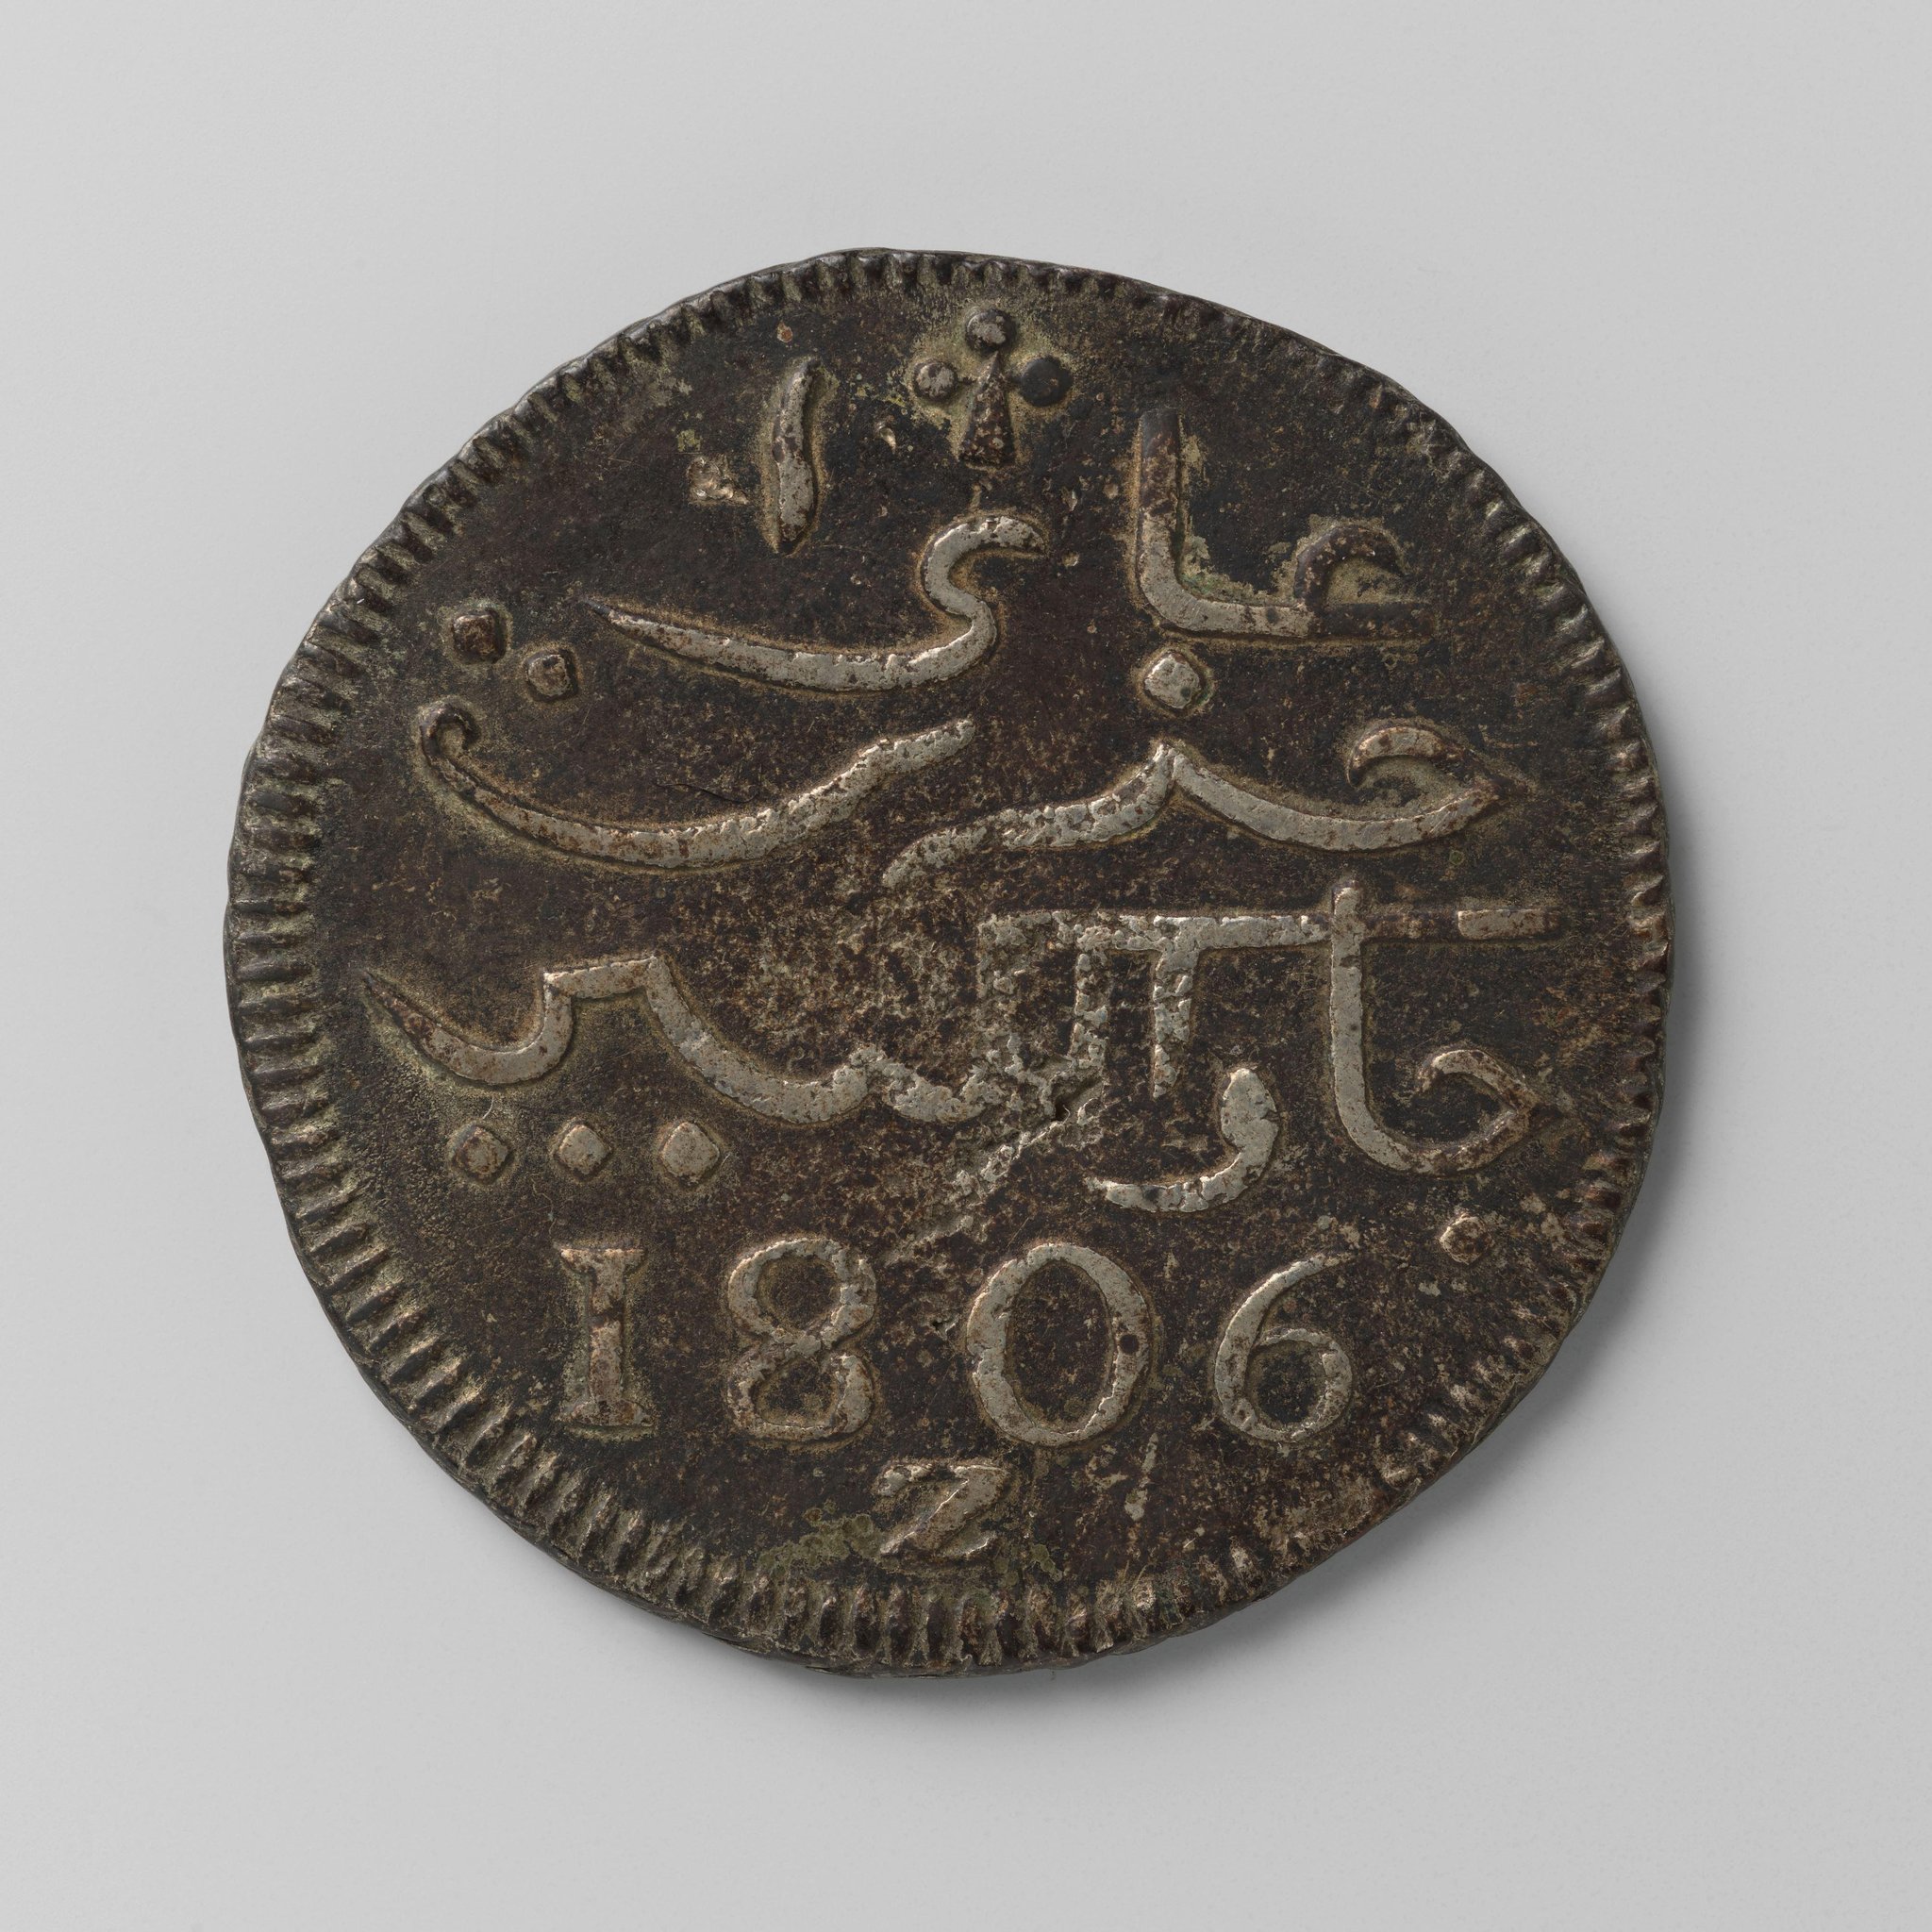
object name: ropij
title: Zilveren ropij van Nederlands Indië uit Java, 1806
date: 1806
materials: silver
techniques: striking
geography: batavia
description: Zilveren munt. Voorzijde: drieregelig opschrift in Arabische letters. Daarboven muntteken en daaronder jaartal, waaronder muntmeesterteken Z [=muntmeester Zwekkert]. Keerzijde: vierregelig opschrift in Arabische letters. Kabelrand.